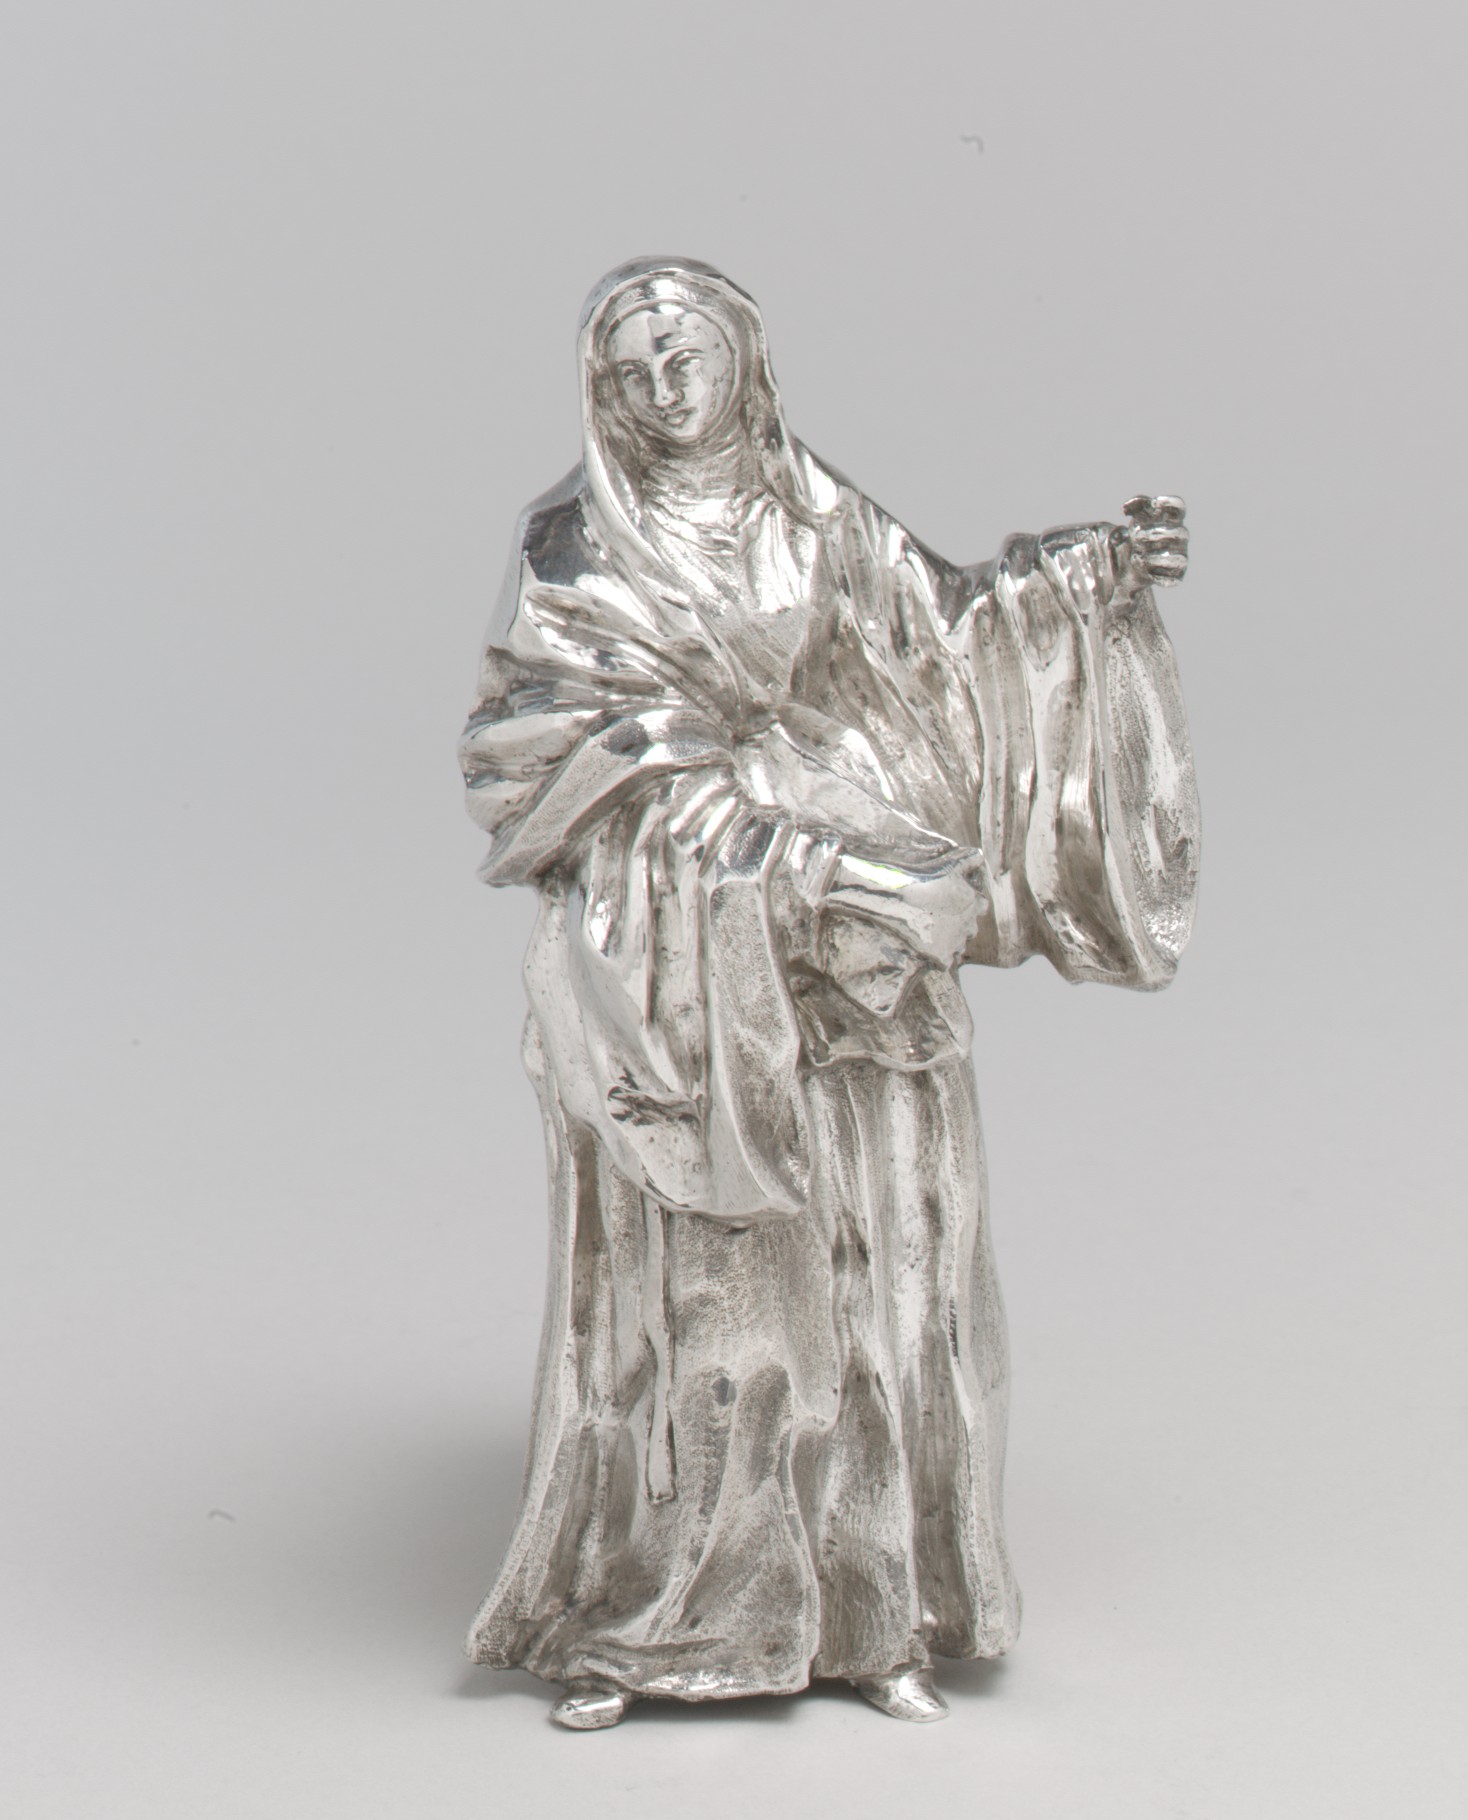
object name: relief statuette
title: The Blessed Catherine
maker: giacomo serpotta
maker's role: artist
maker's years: 1656-1732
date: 1762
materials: silver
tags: women